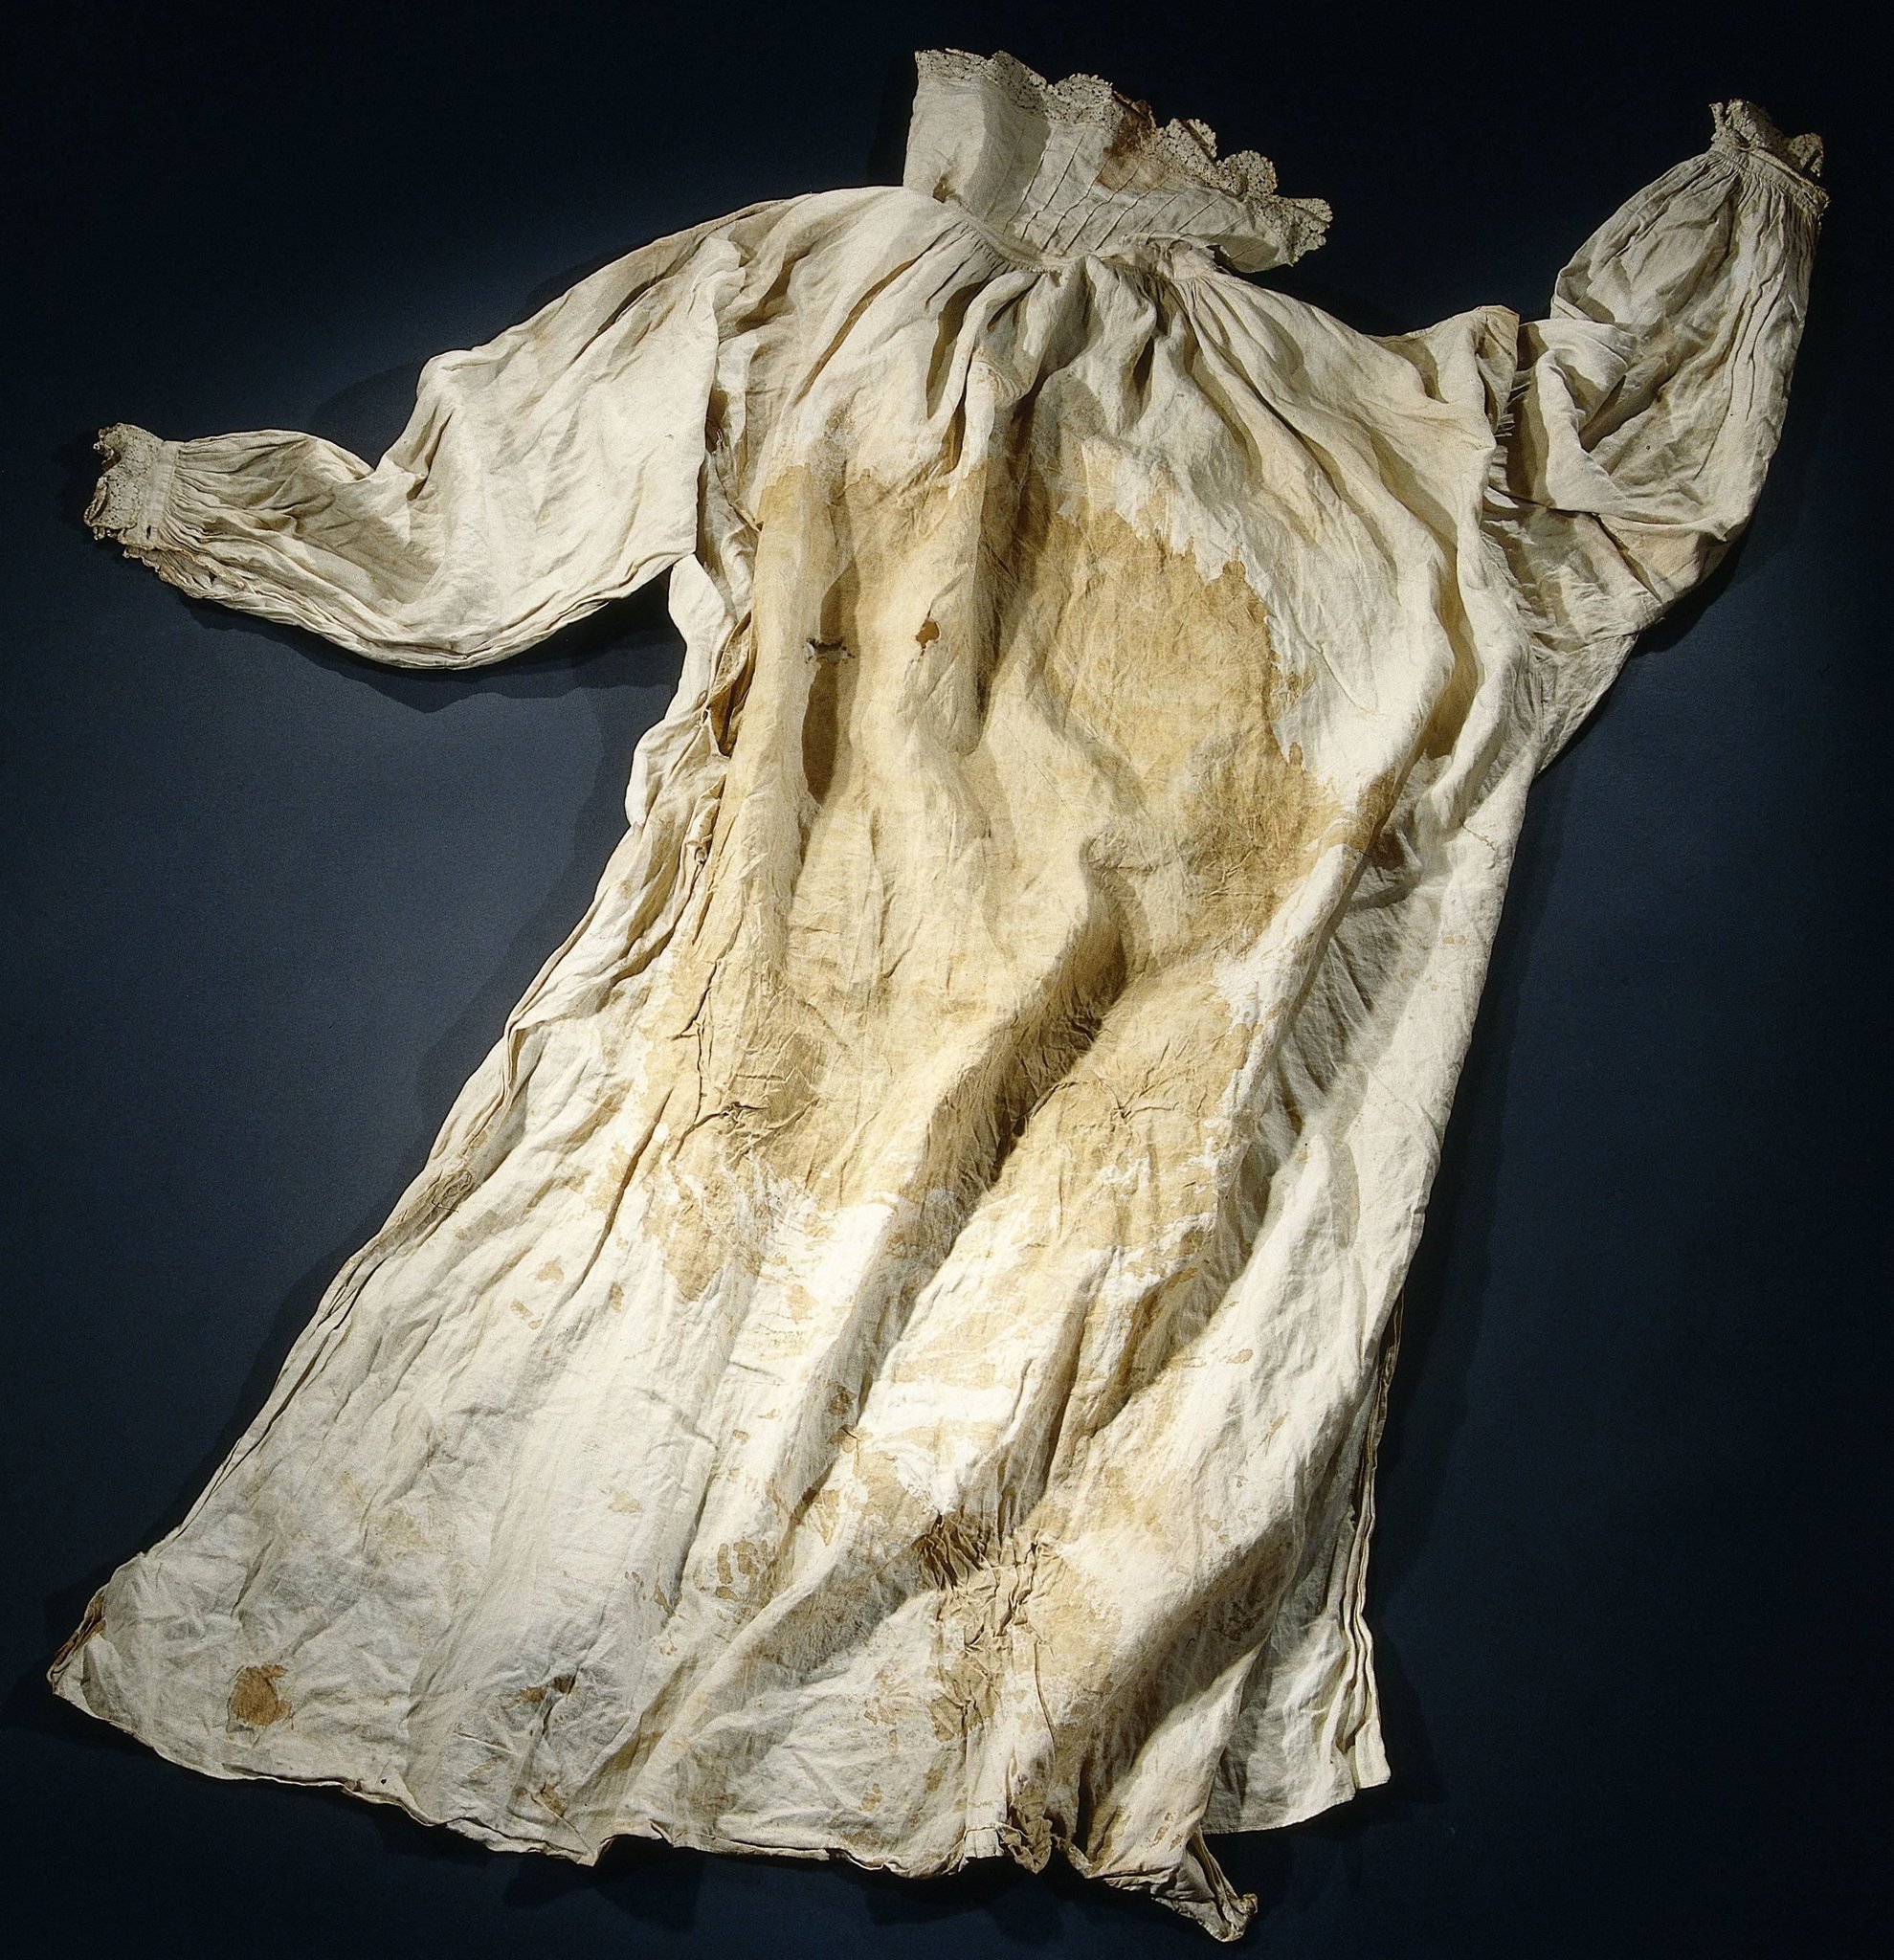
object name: menswear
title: Hemd, mogelijk gedragen door Hendrik Casimir tijdens de bestorming van een fort bij Hulst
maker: Anonymous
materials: linen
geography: netherlands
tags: arnhem, hendrik casimir i graaf van nassau-dietz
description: Tijdens het beleg van Hulst werd Hendrik Casimir op 6 juli 1640 van zijn paard geschoten. Hij stierf acht dagen later.